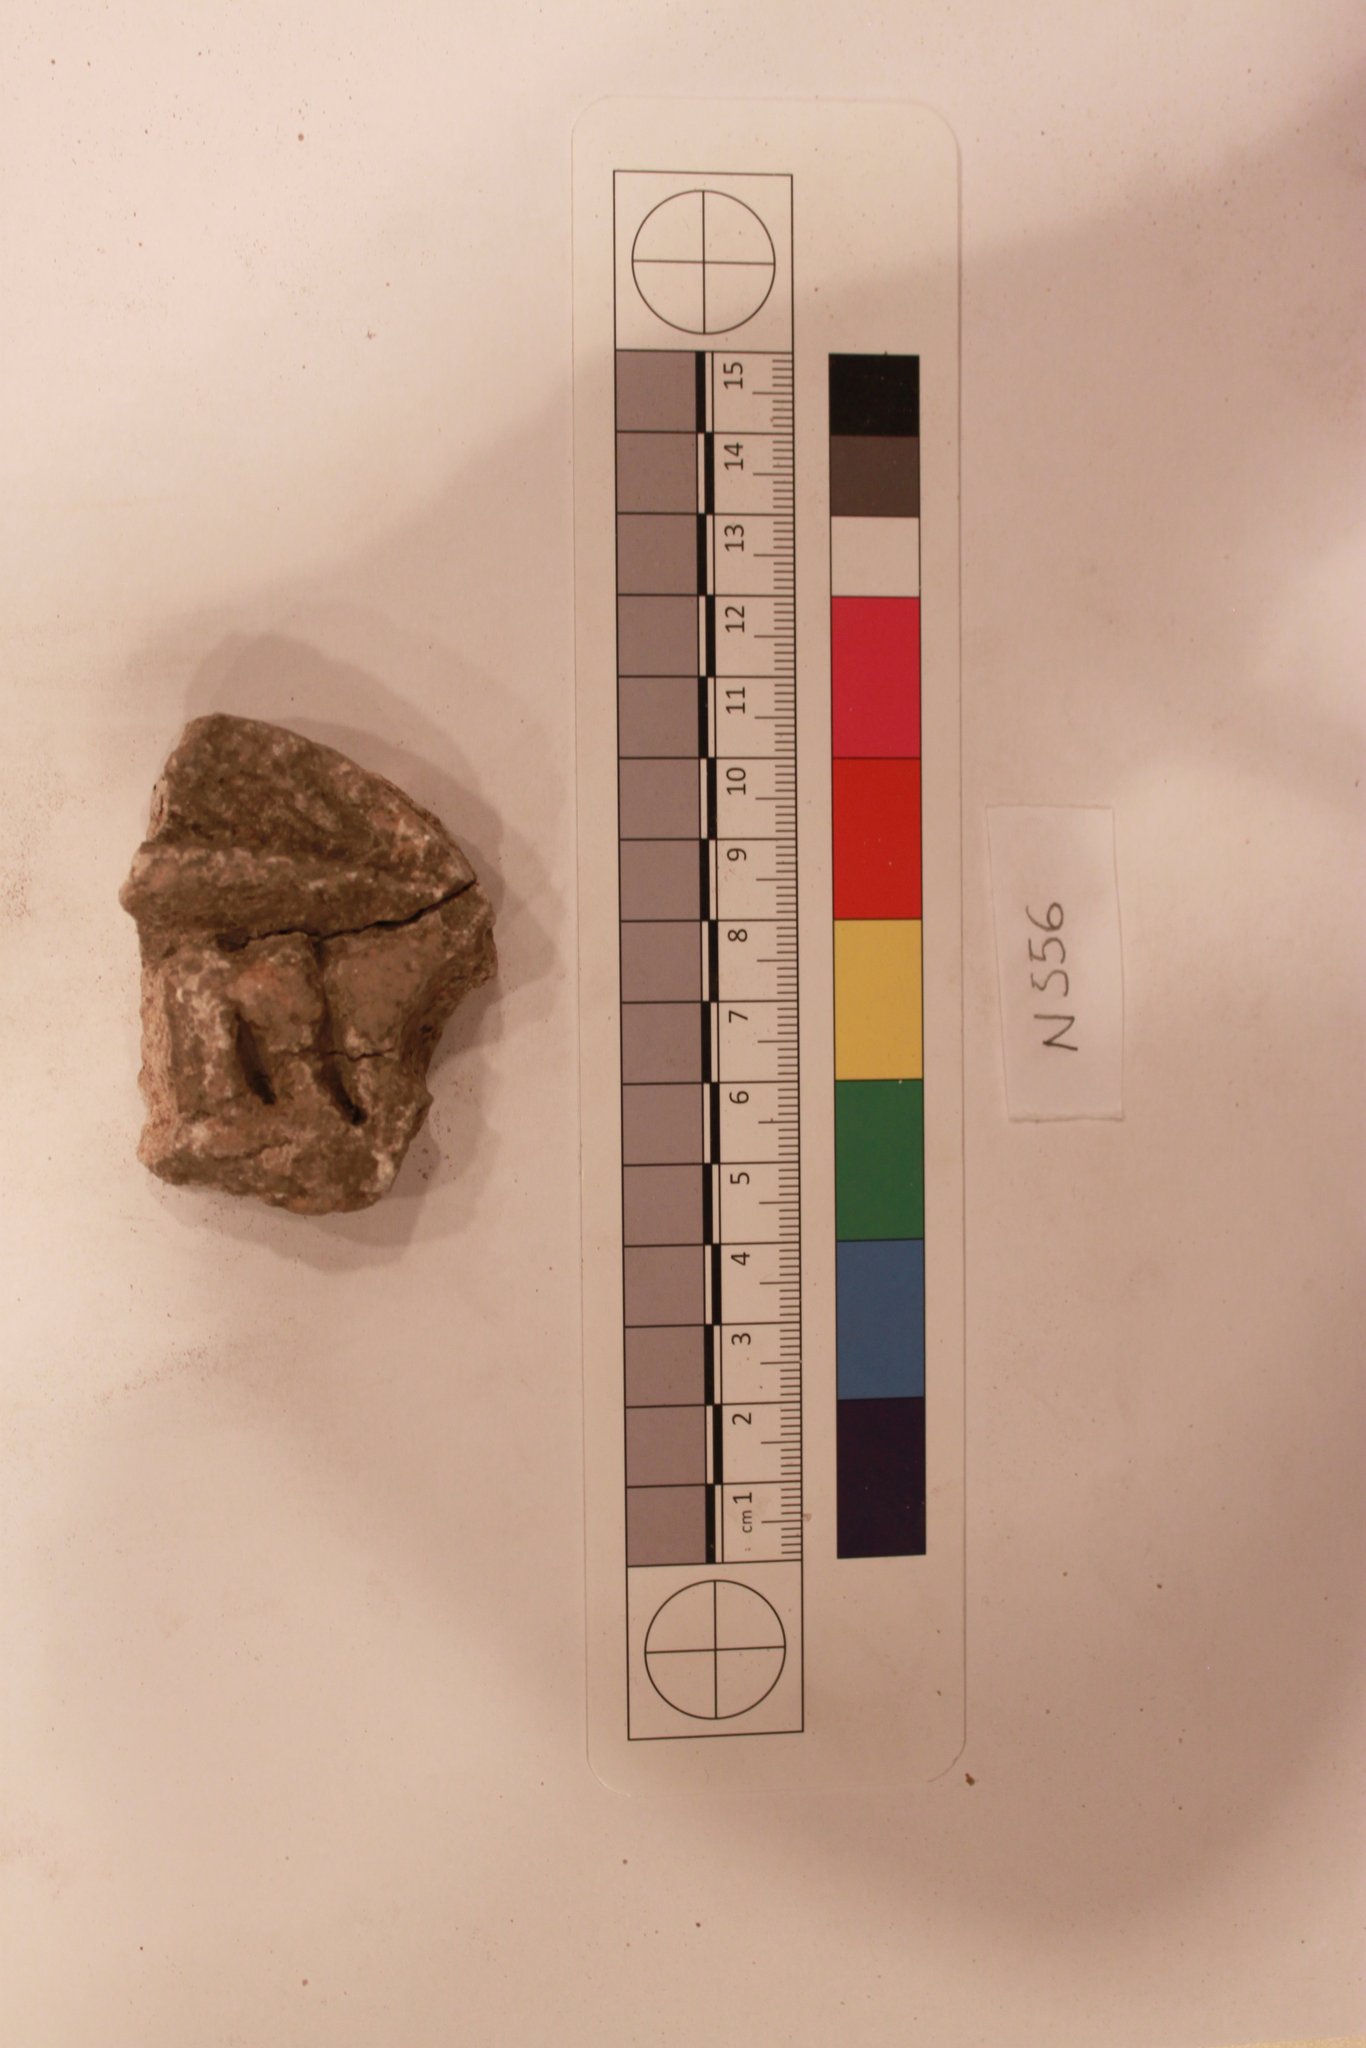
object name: fragment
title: Stucco Fragment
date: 701-1200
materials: plaster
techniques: carving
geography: iran